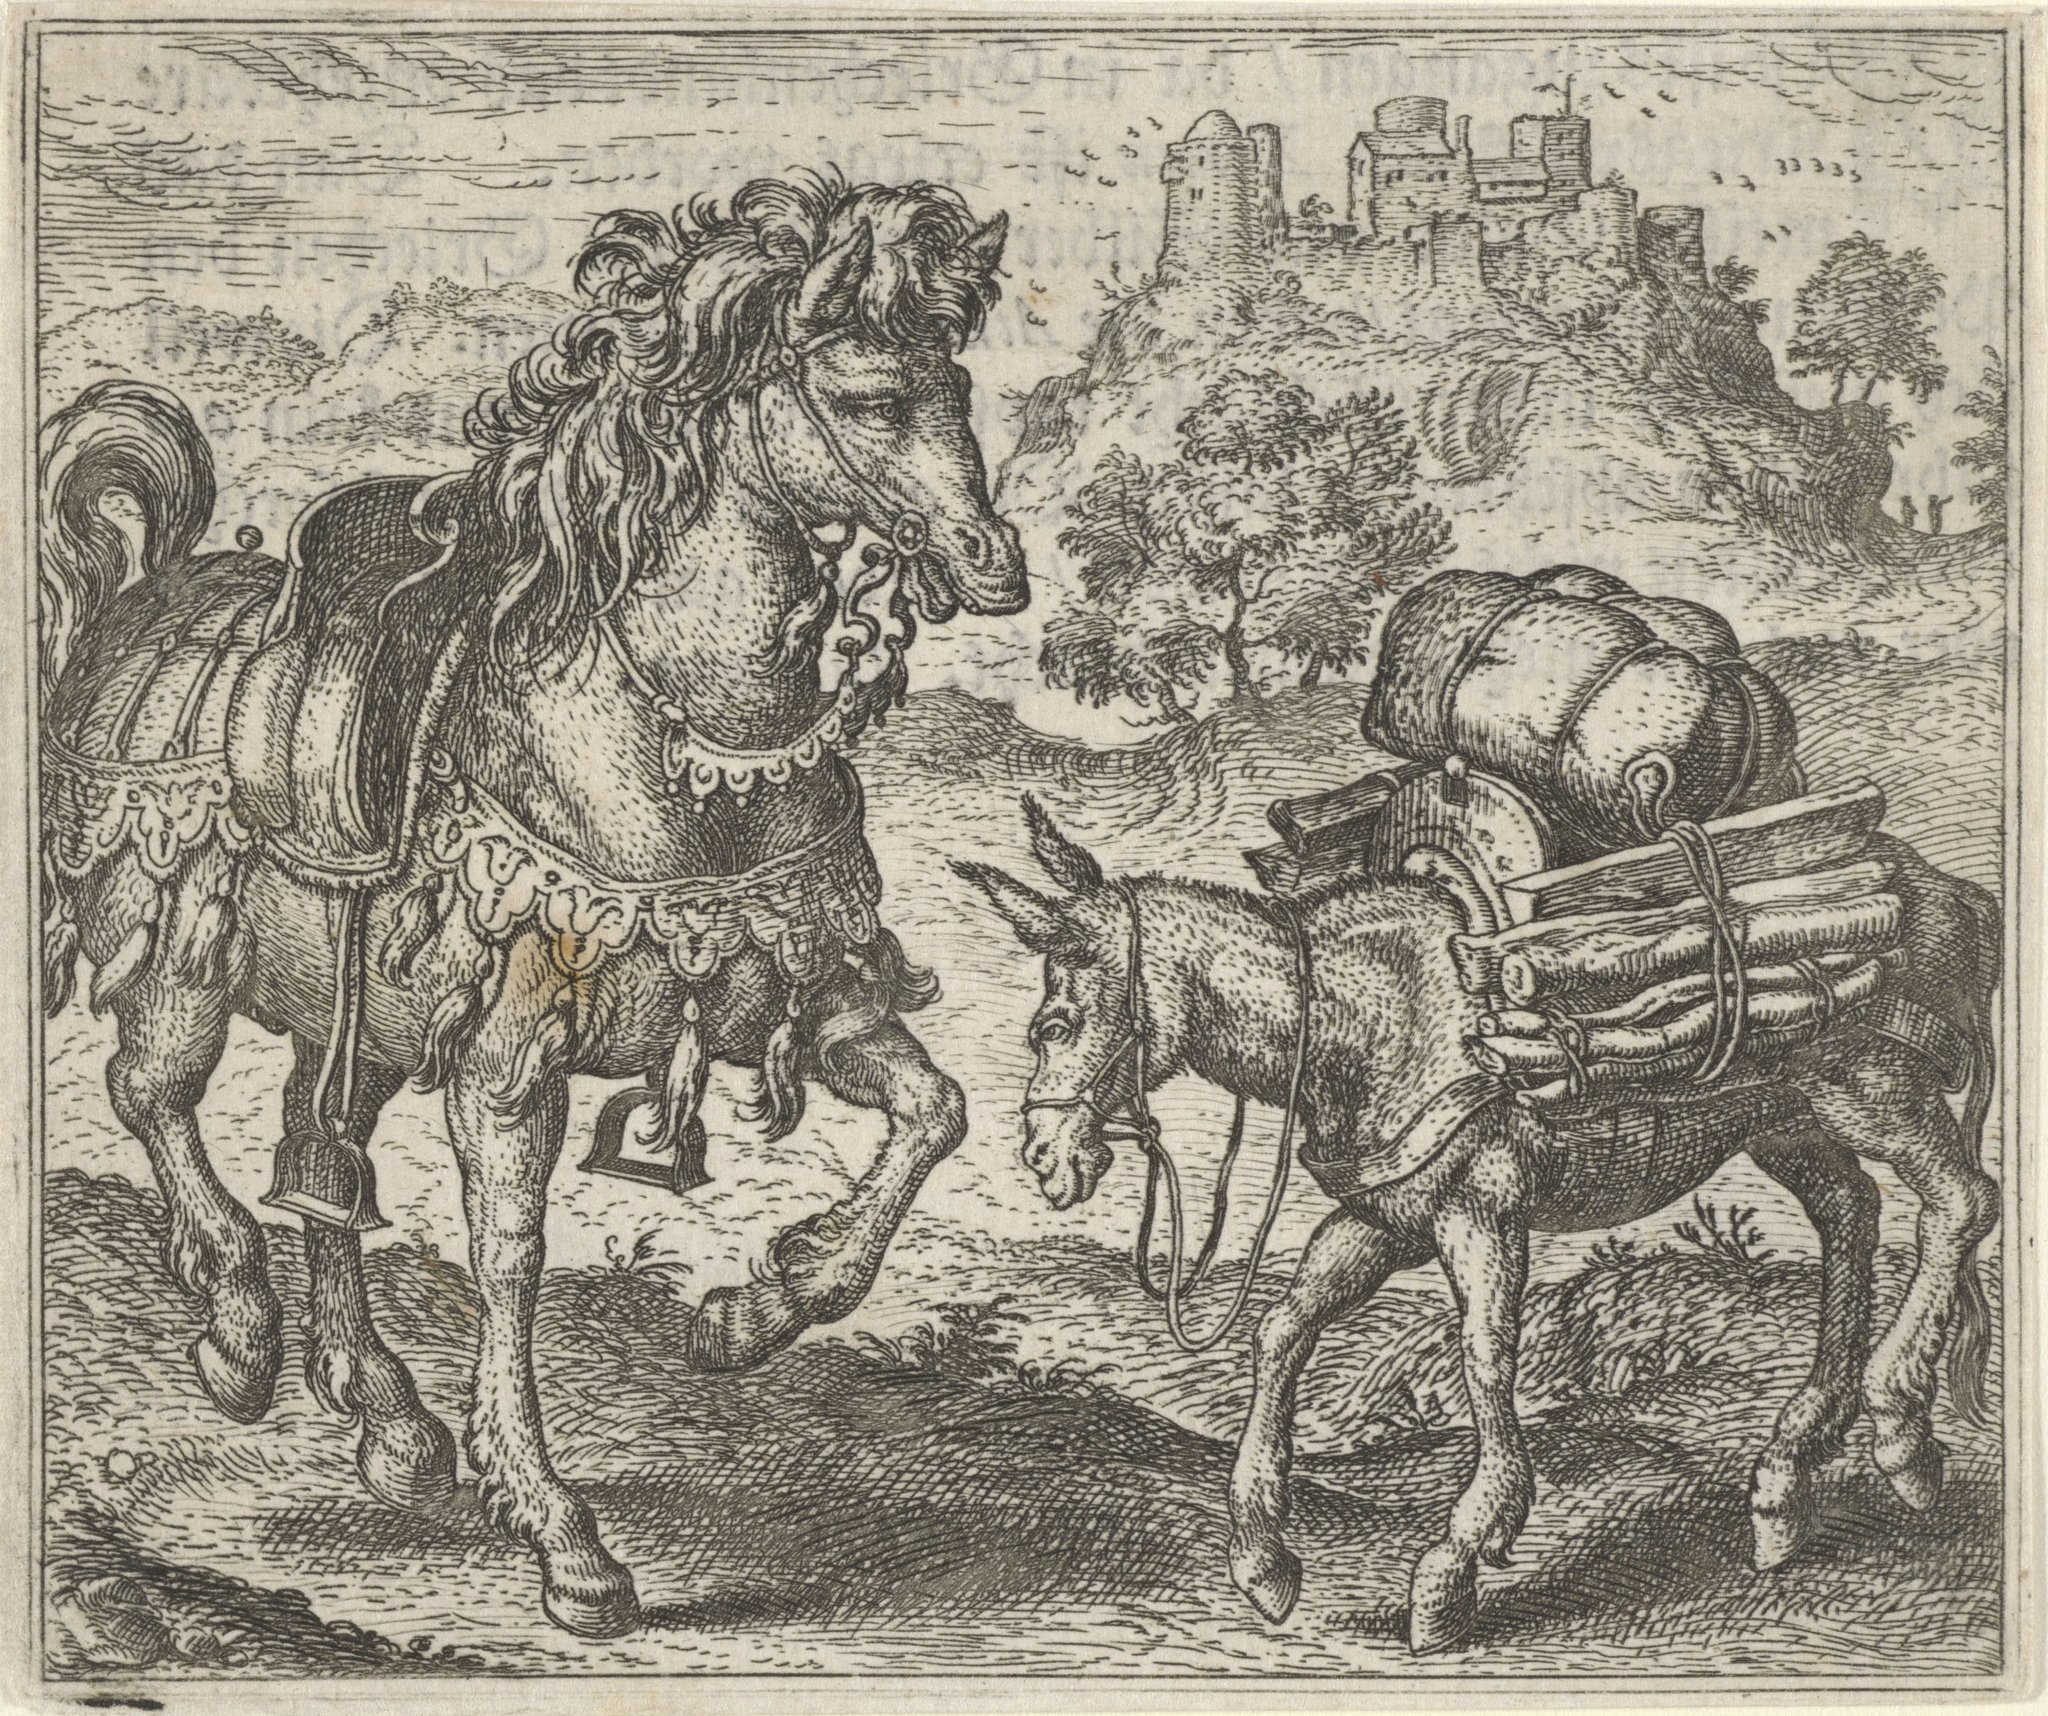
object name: book illustration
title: Fabel van de ontevreden ezel en het strijdros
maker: aegidius sadeler (ii)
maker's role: draughtsman, print maker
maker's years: 1568-1629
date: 1608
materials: paper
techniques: engraving, etching, letterpress printing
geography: prague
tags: ass, donkey, battle (+ cavalry, horsemen), fables, horse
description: Rechts een ezel, zwaar bepakt met goederen. Links een strijdros. De fabel beschrijft een ezel die ontevreden is over zijn leven. Hij ontmoet een strijdros dat moet vechten in de oorlog. Een ezel heeft een veiliger bestaan dan een strijdros. De moraal van het verhaal leert dat ieder mens tevreden moet zijn met het leven dat hij heeft.